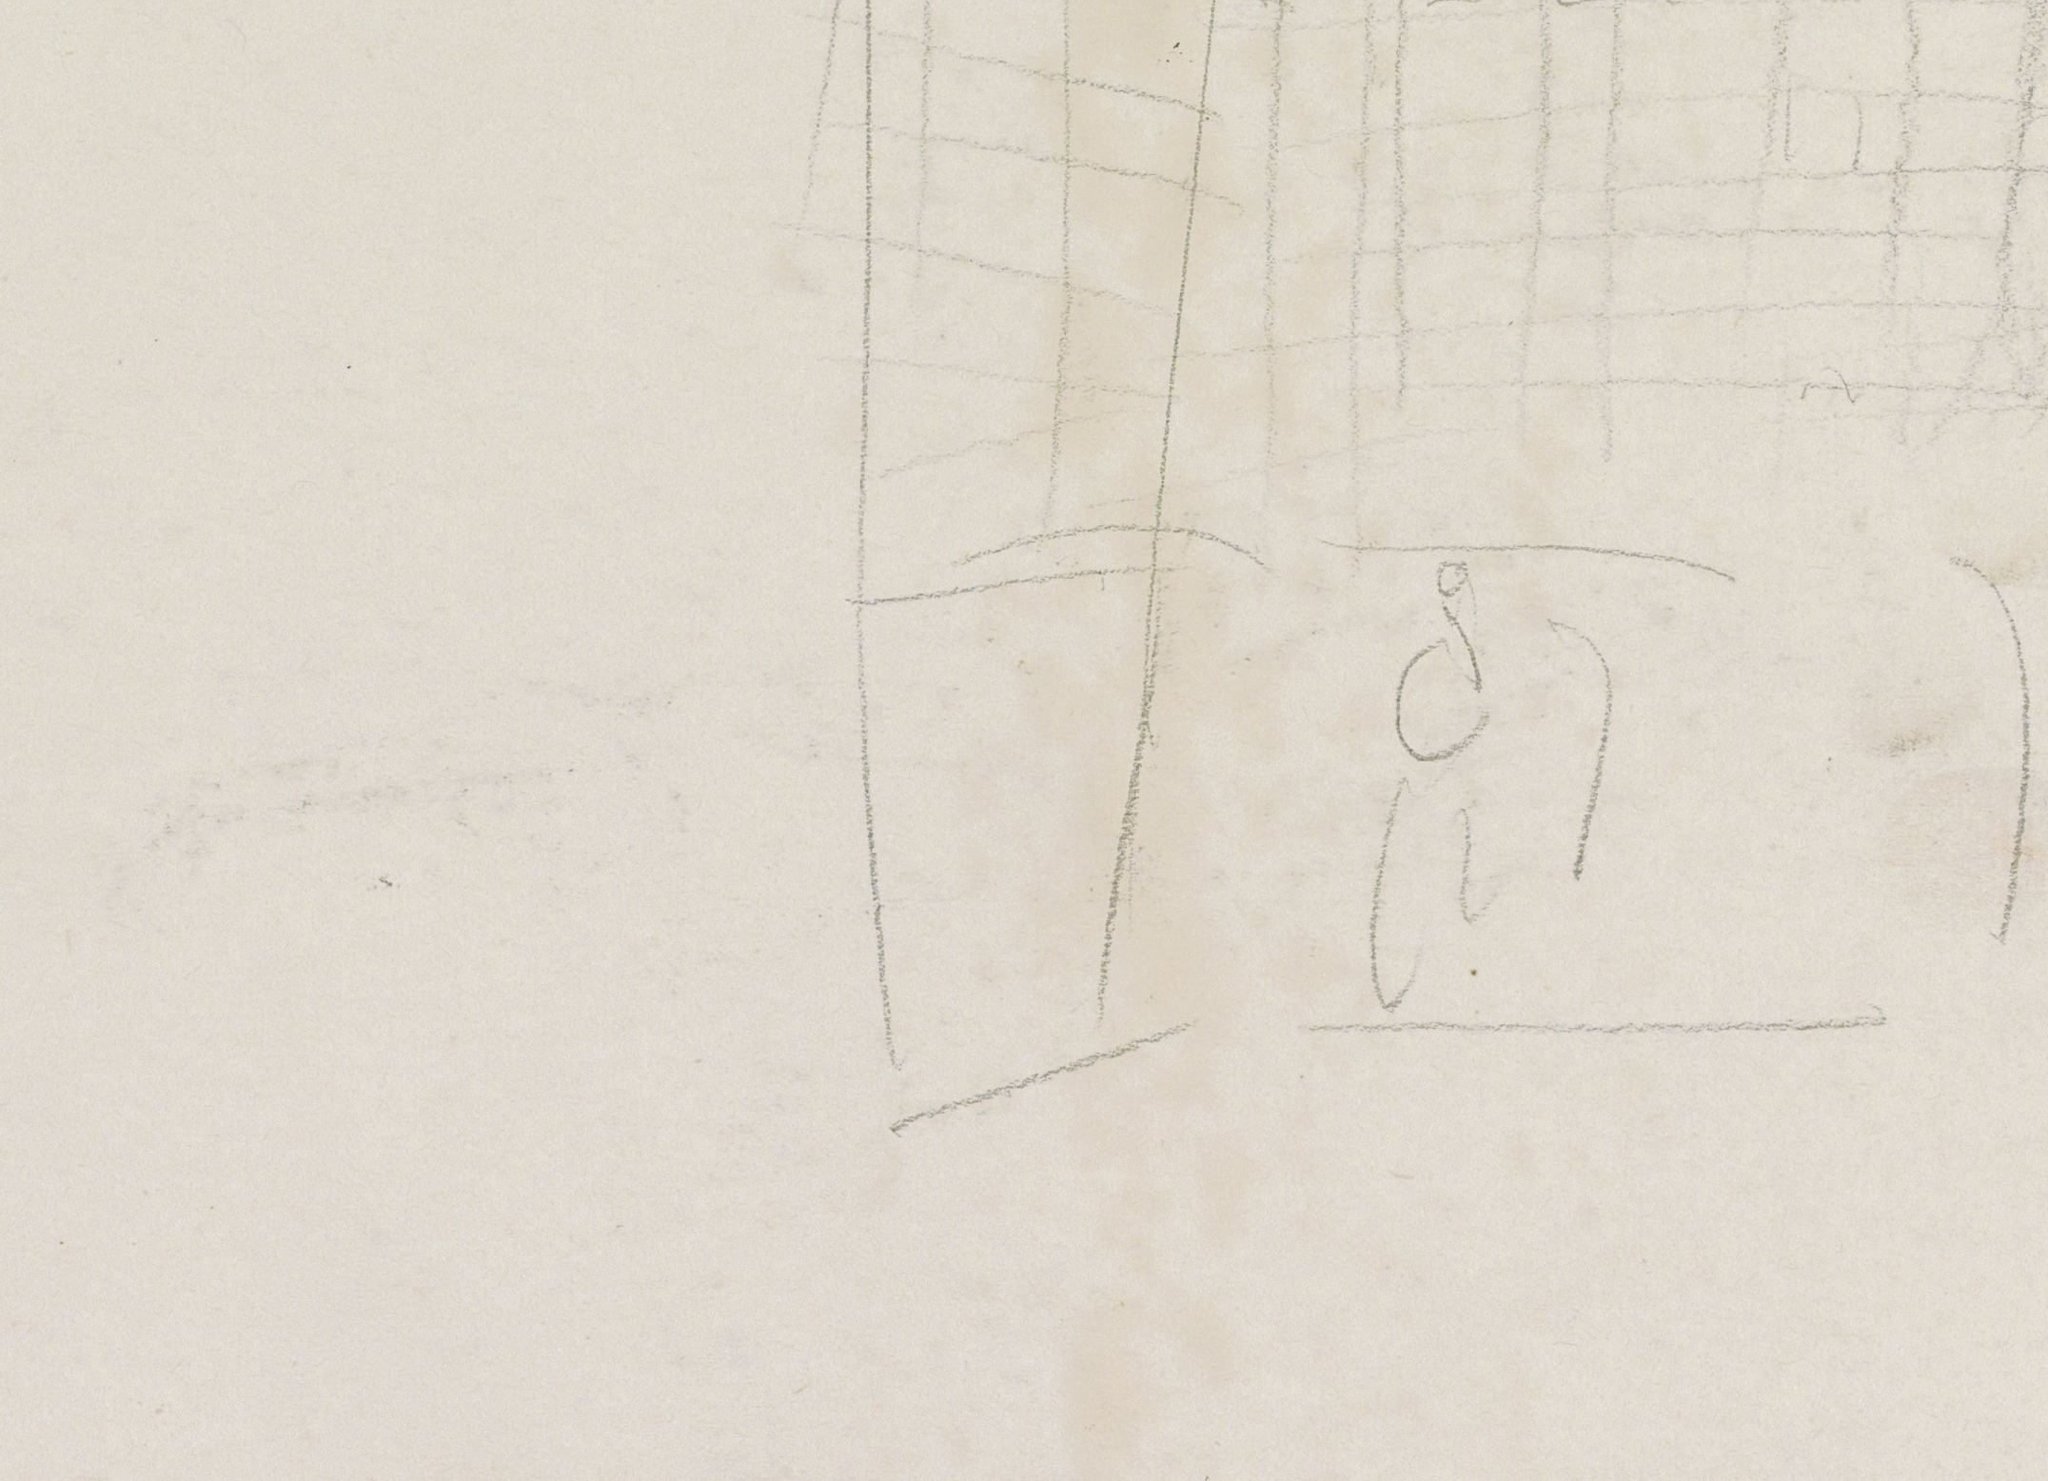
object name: sketchbook leaf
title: Studie, mogelijk een compositiestudie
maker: isaac israels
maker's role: draughtsman, painter, print maker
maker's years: 1865-1934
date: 1915-1934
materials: paper, pencil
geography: the hague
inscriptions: annotation: ‘Mej C Molenbroek / v Kinsbergenstr 170’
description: Schutblad B, achterste schutblad, uit schetsboek VI met 33 bladen.